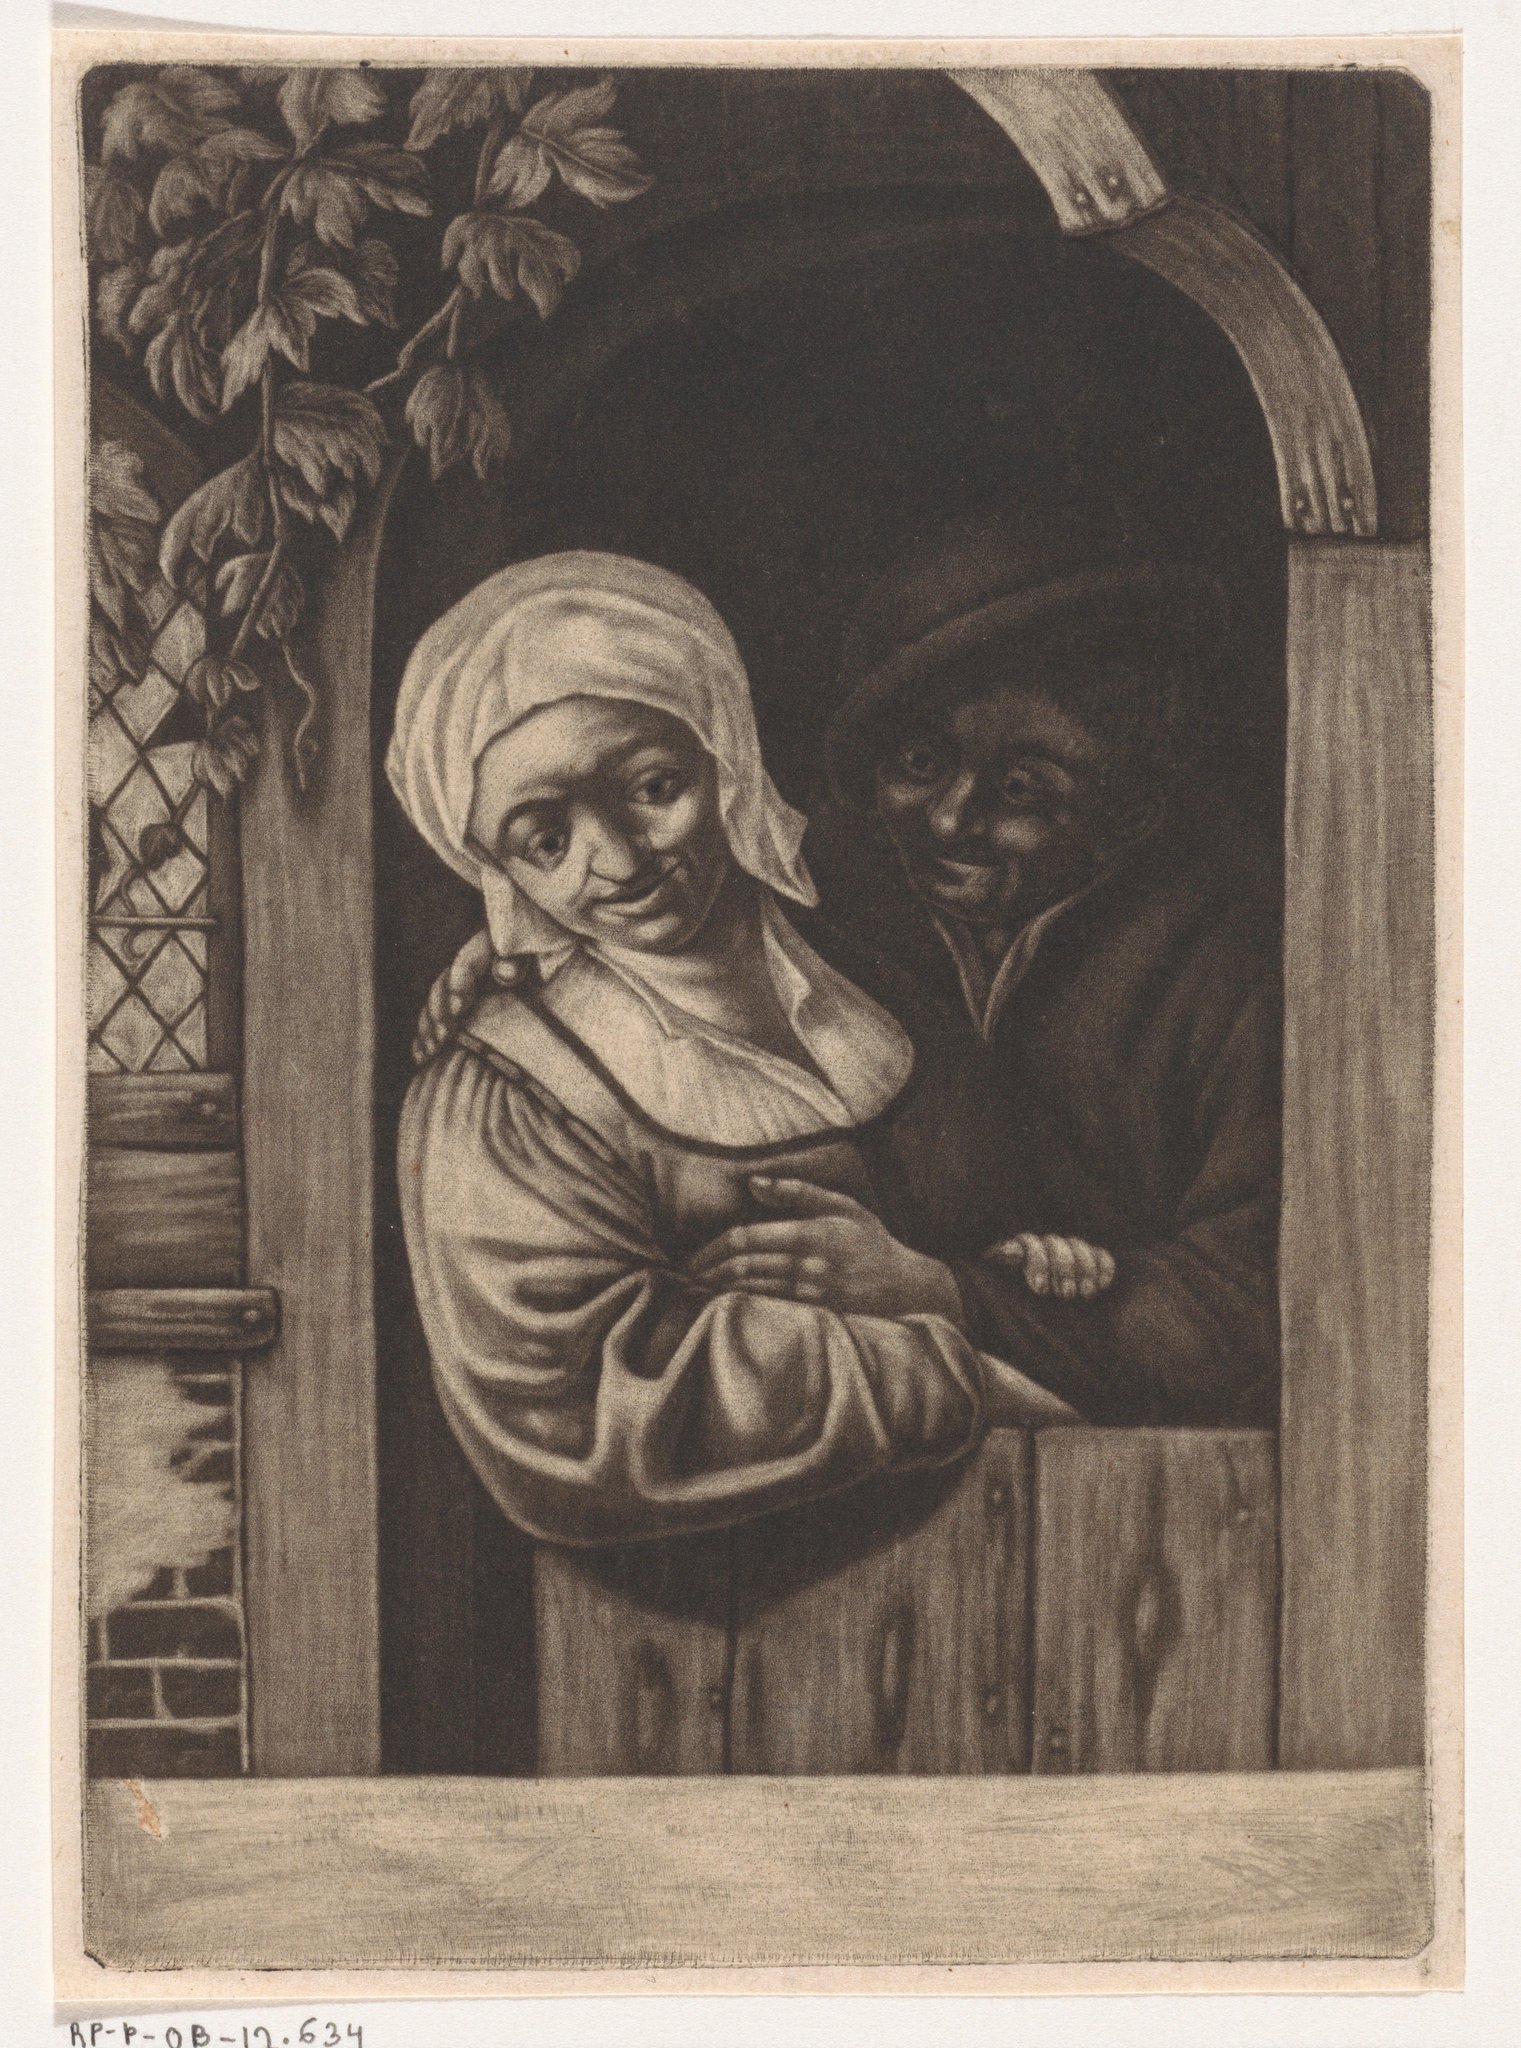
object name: print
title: Man en vrouw in een deuropening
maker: Anonymous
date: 1688-1694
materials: paper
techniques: mezzotint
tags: open door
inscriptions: collector's mark: Lugt 2228